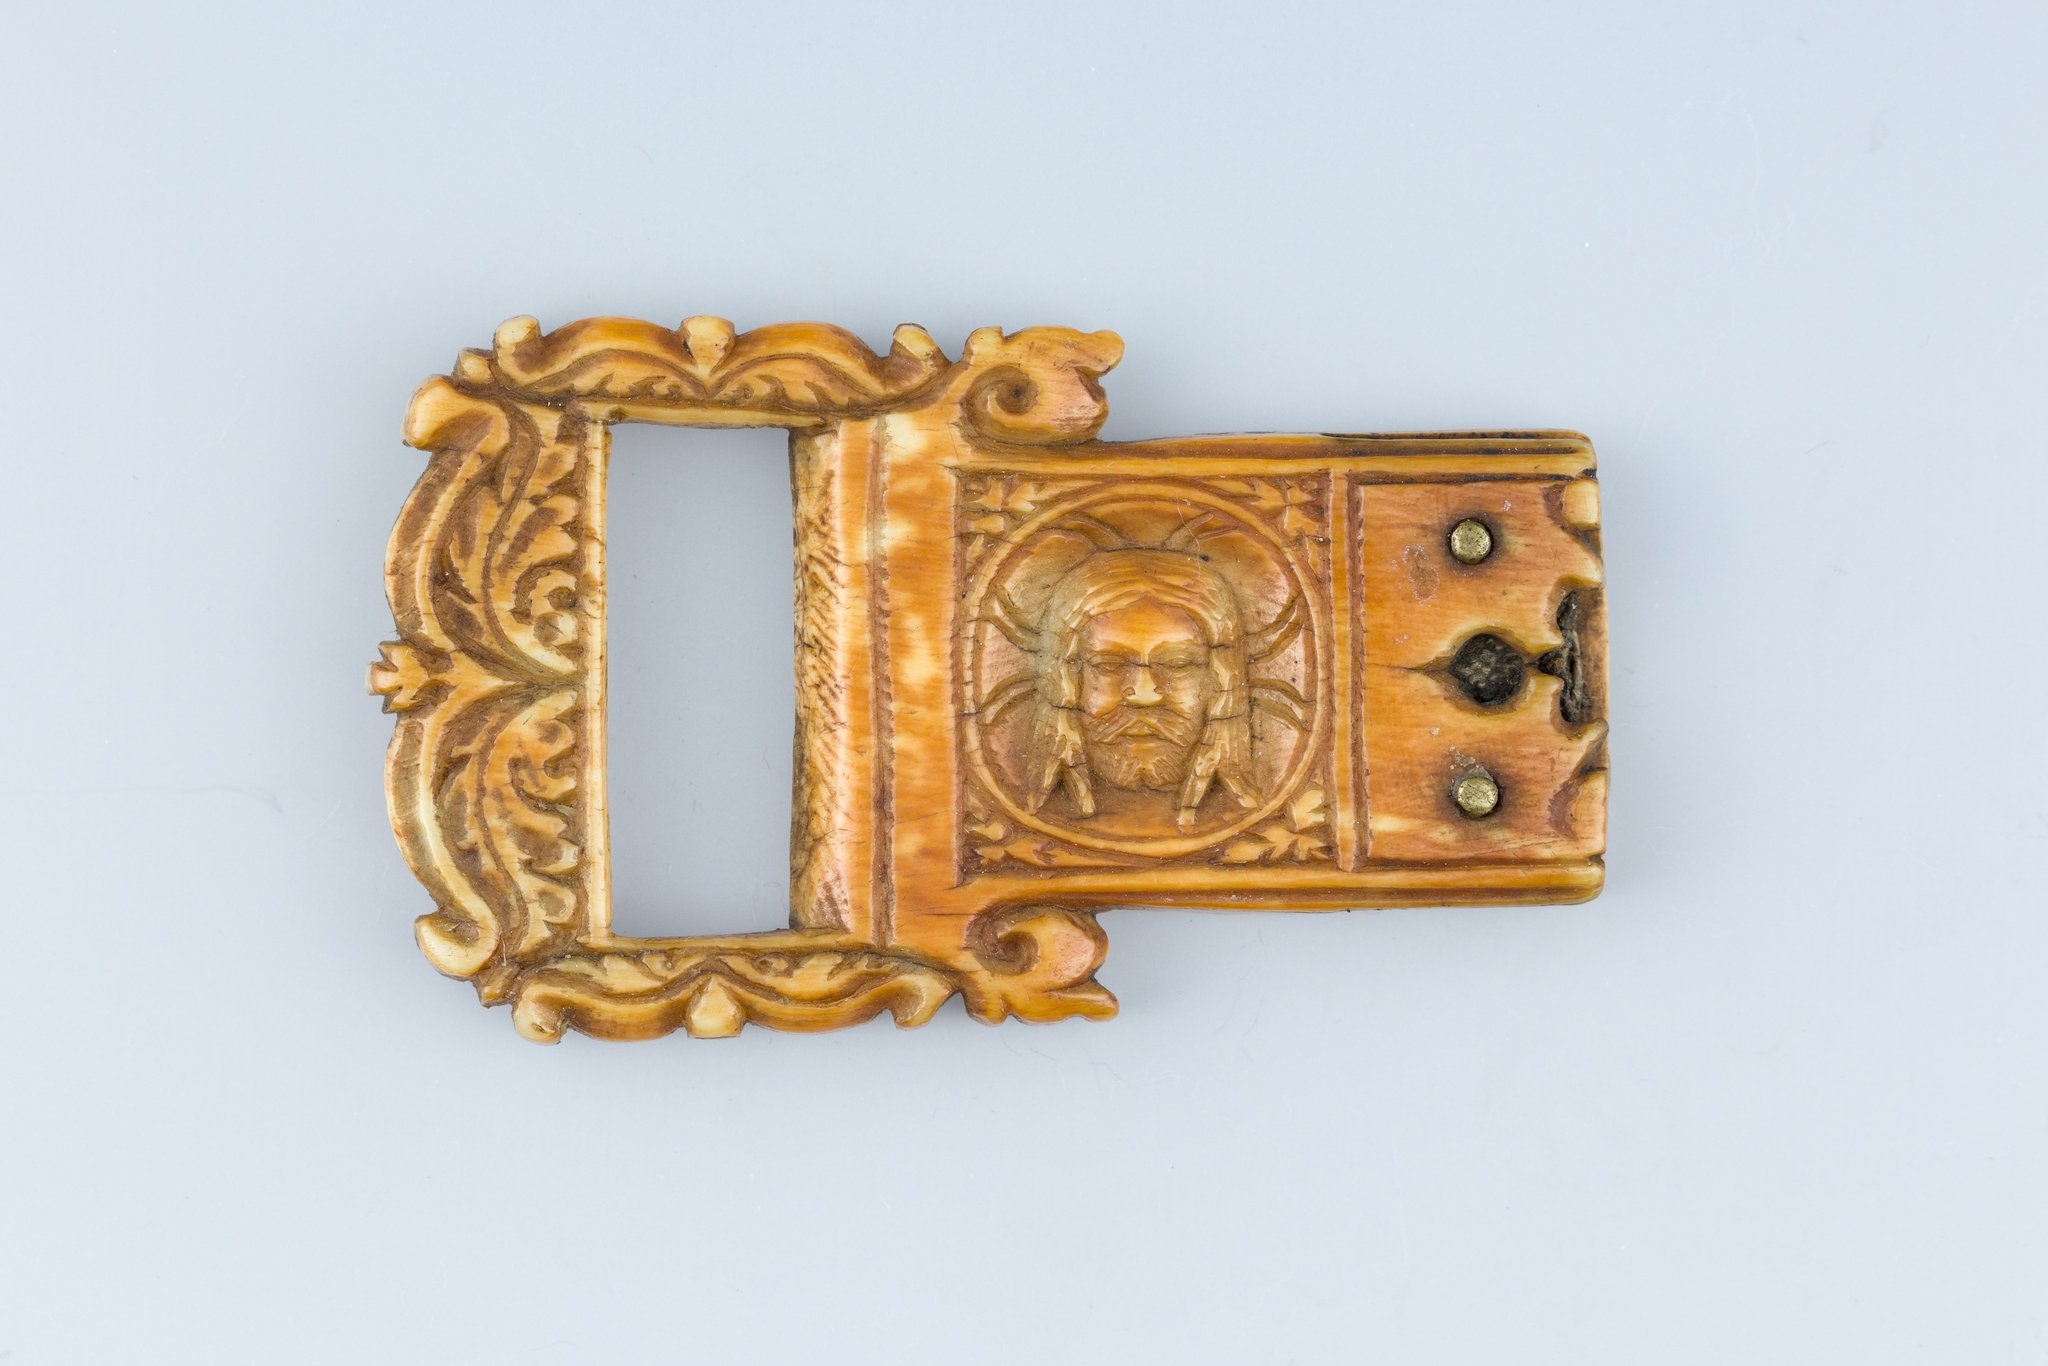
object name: buckle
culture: french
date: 1501-1533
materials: ivory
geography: france